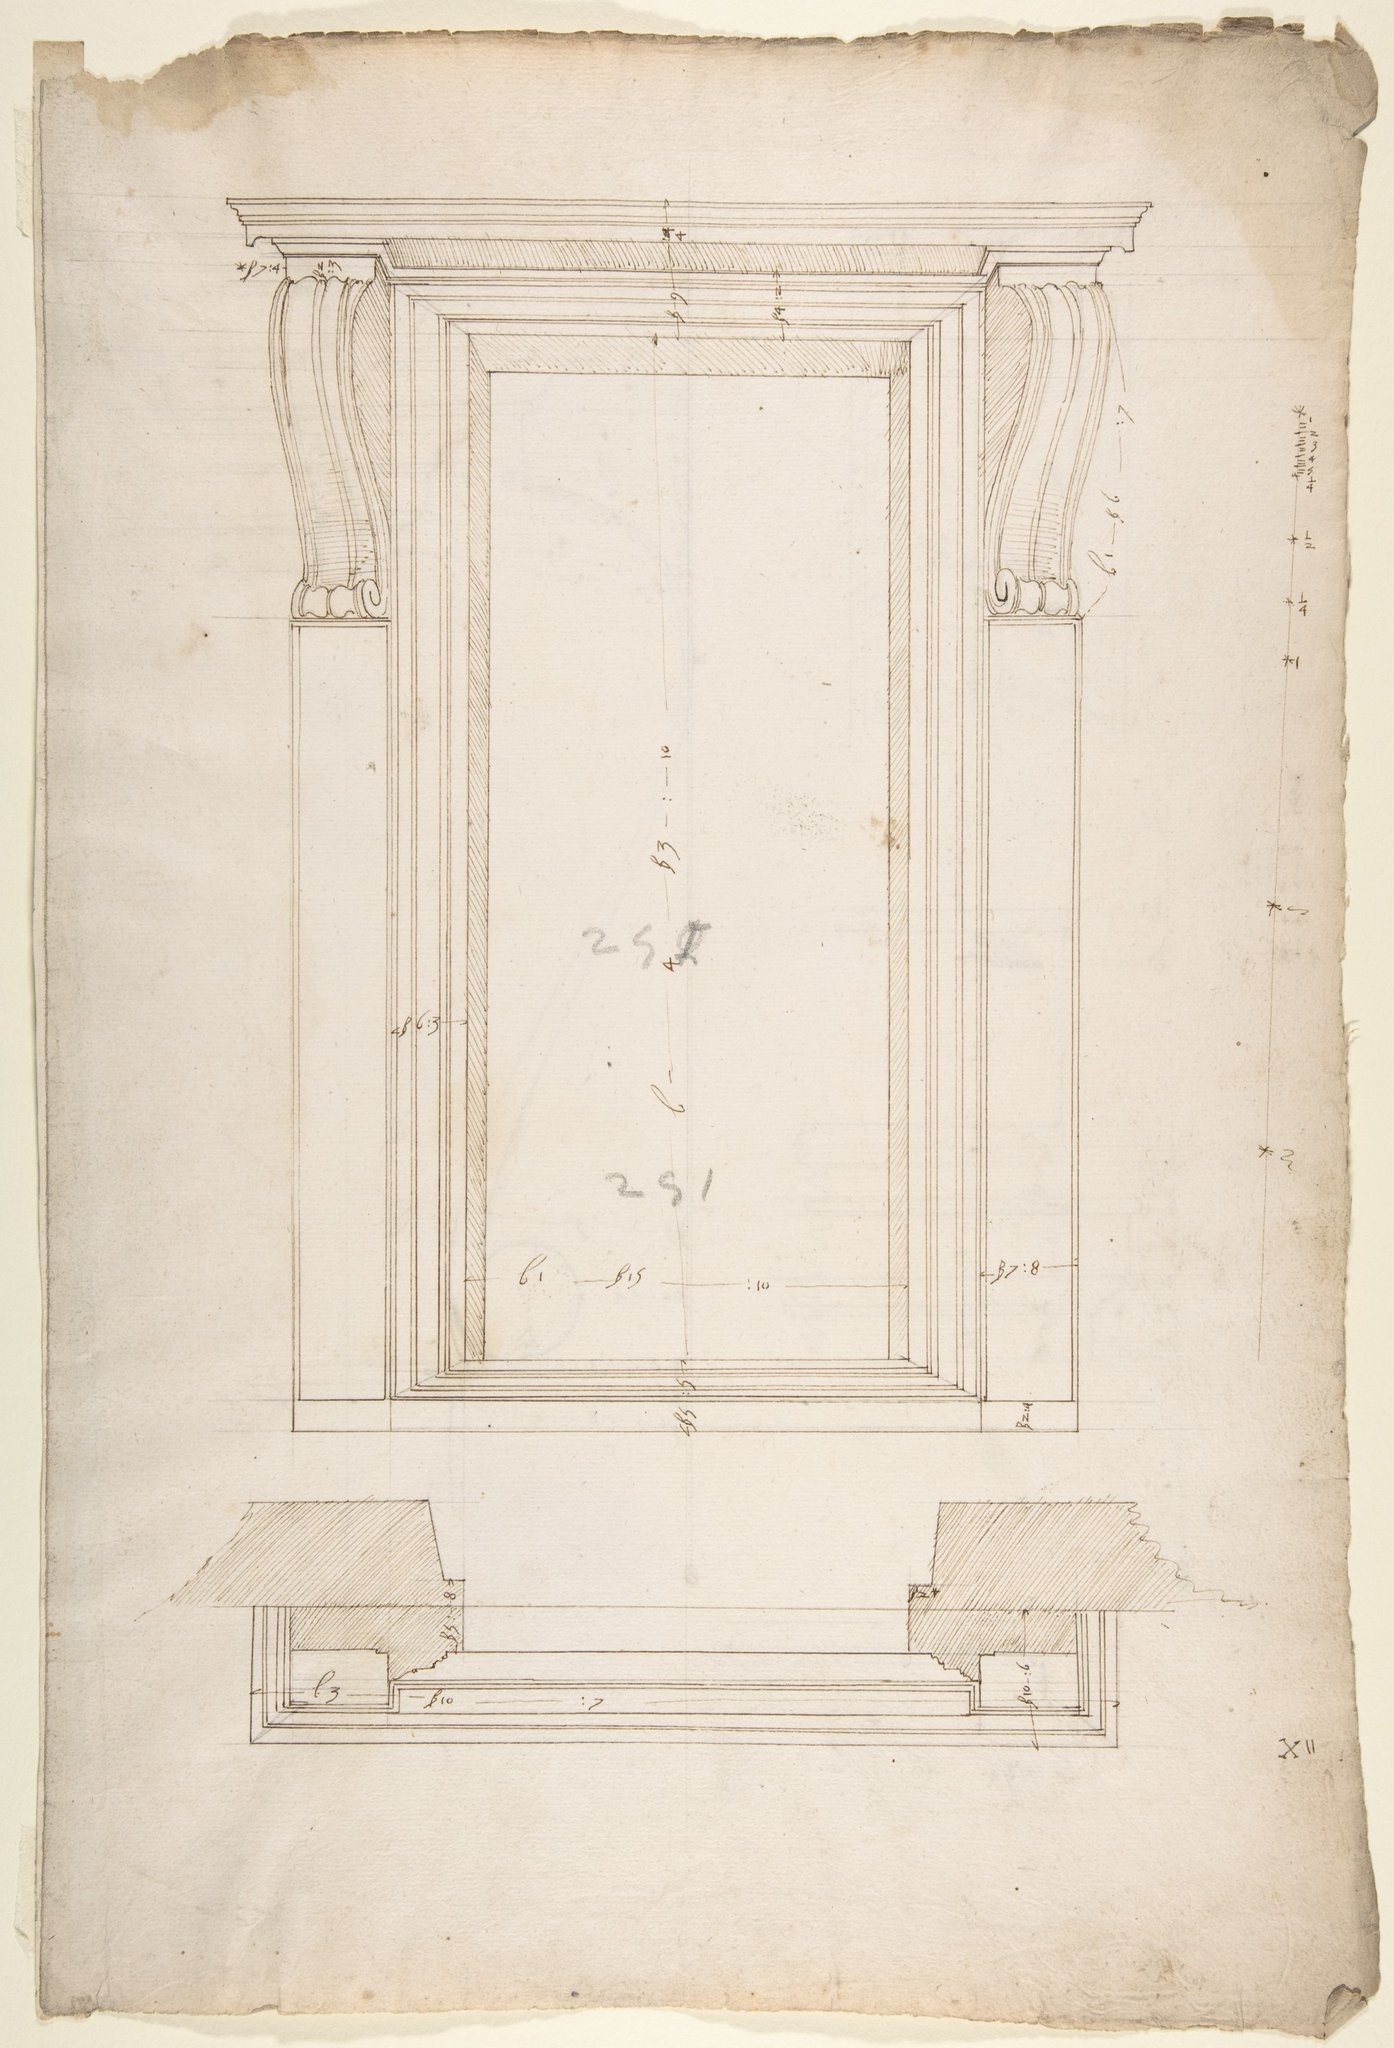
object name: drawing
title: San Lorenzo, New Sacristy, portal, plan; elevation (recto) San Lorenzo, New Sacristy, portal, details (verso)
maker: anonymous, french, 16th century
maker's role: draftsman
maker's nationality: french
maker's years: 1500-1600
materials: chalk, ink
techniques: incising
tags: architecture